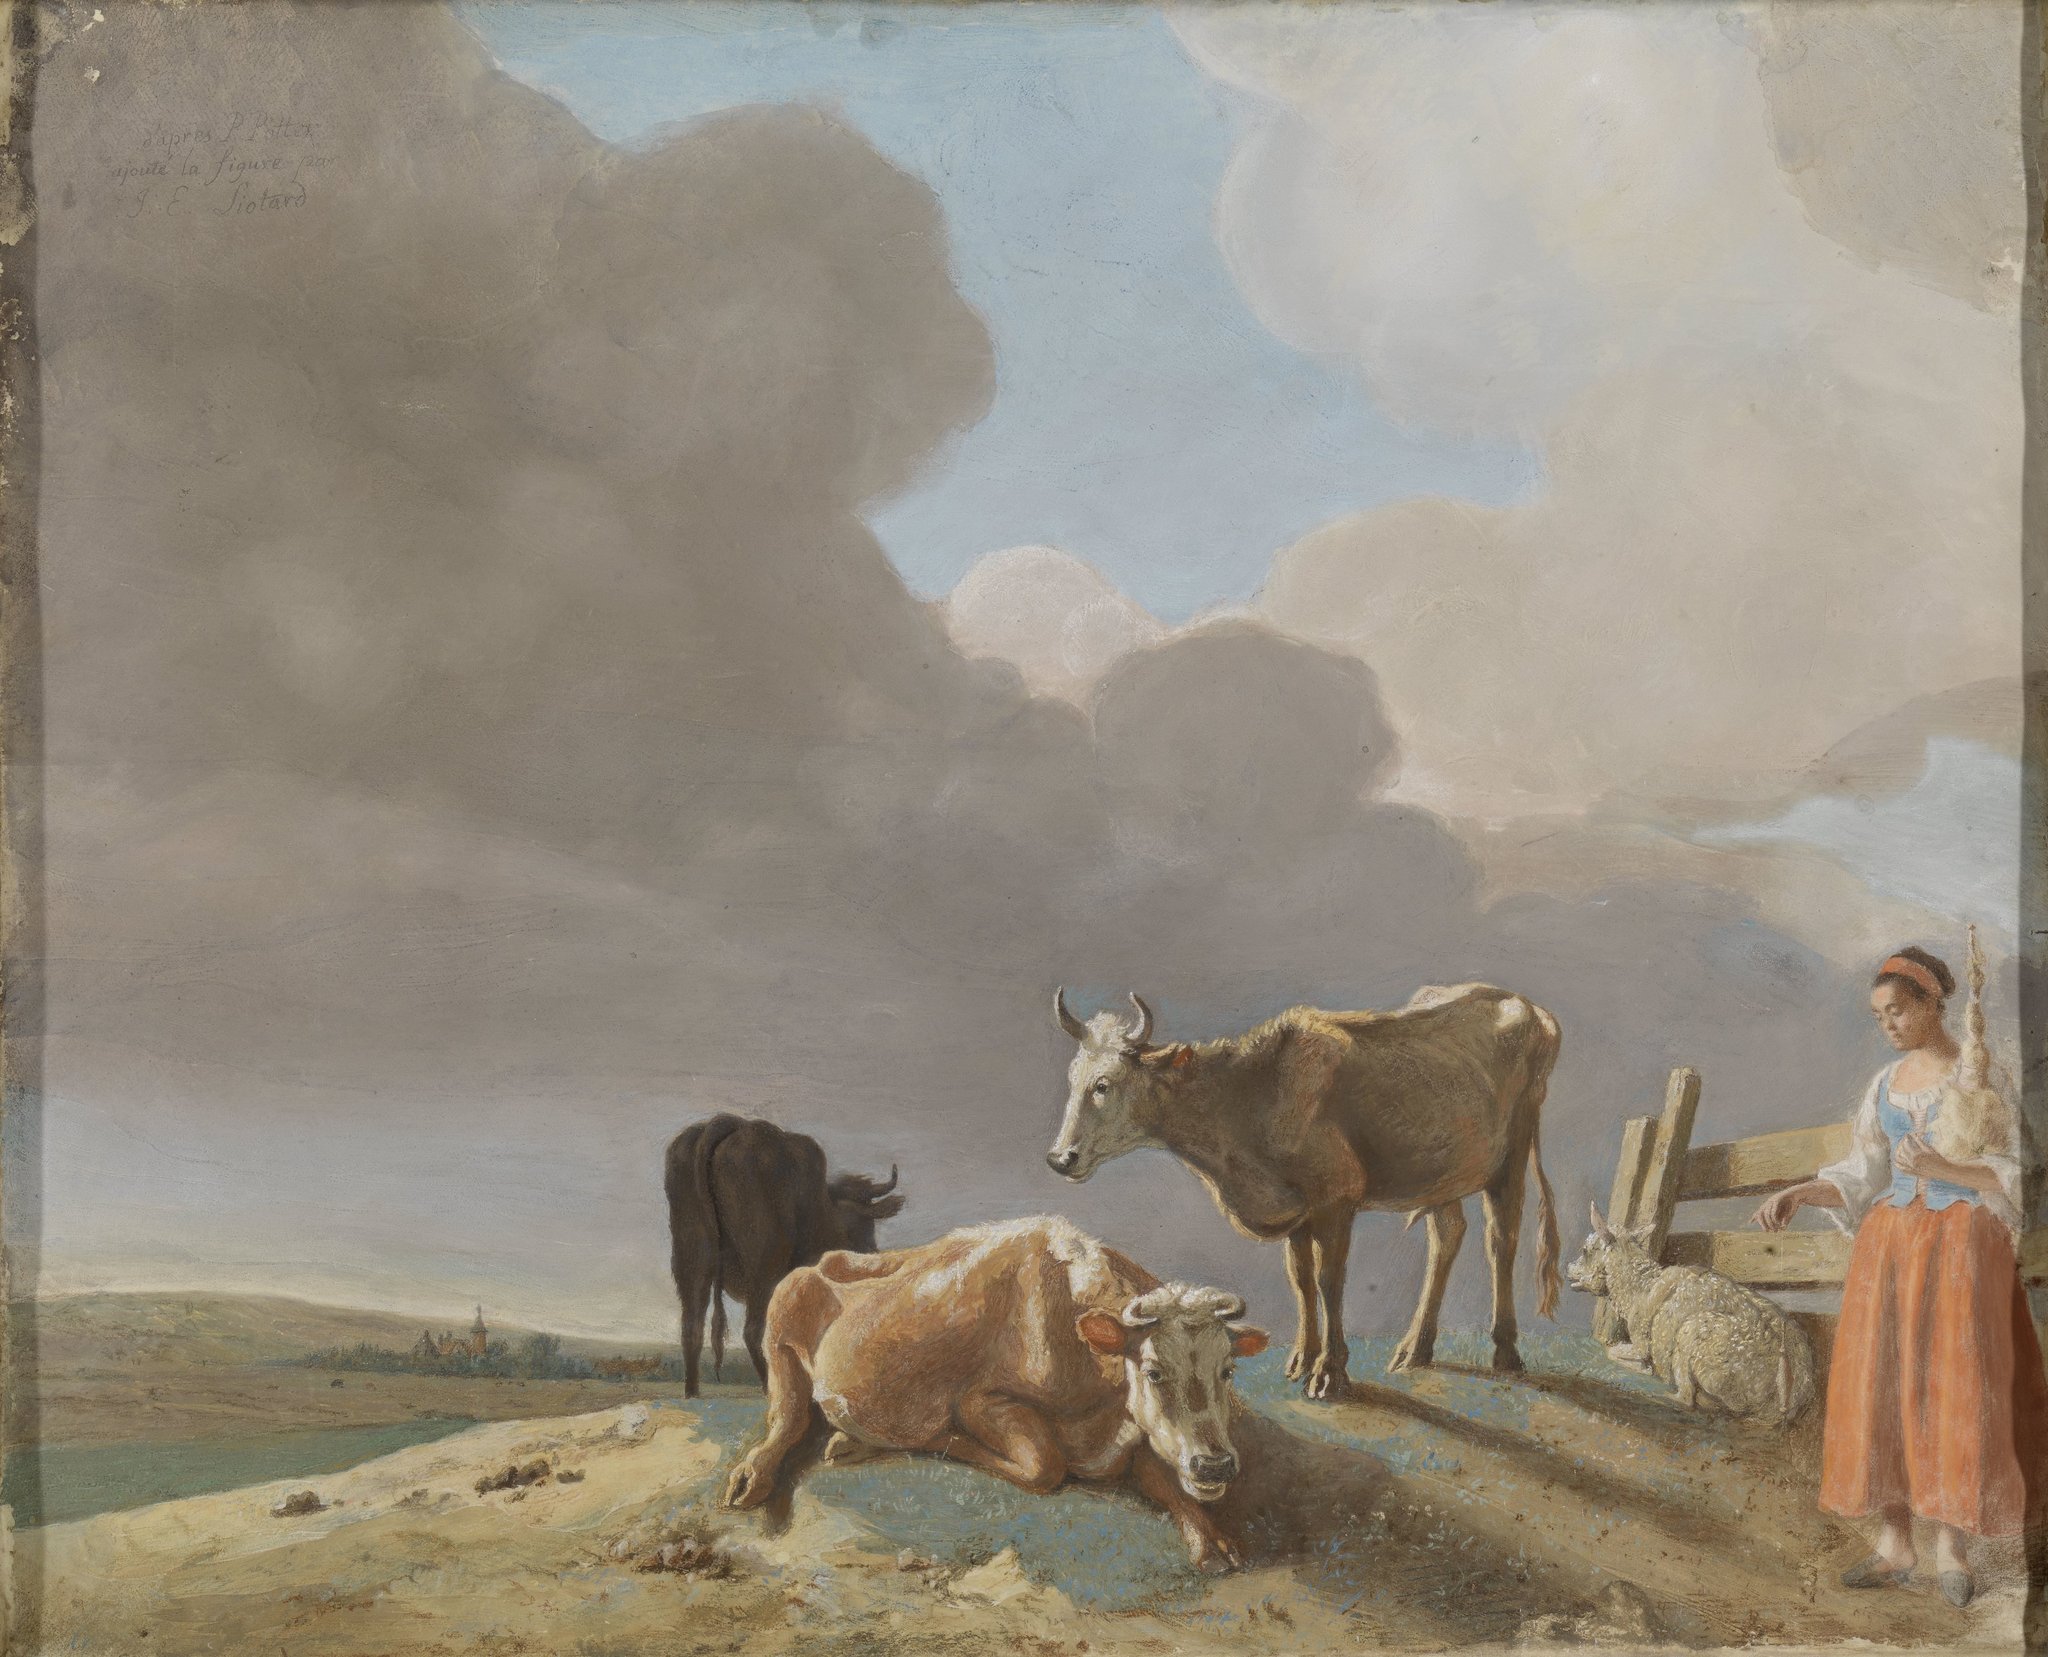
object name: pastel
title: Landschap met koeien, schapen en herderin, gewijzigde kopie naar een schilderij van Paulus Potter, de herderin gekopieerd van een schilderij van Karel Dujardin (recto); onvoltooid portret van een man (verso)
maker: jean-etienne liotard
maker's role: painter, print maker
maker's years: 1702-1789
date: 1761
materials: parchment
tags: cow, spinning (manufacture of yarn)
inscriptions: inscription: ‘d'après P. Potter, ajouté la figure par J.E. Liotard’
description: Jean-Etienne Liotard (1702 - 1789). Unfinished portrait of a man (verso). J.W.R. Tilanus bequest, 1885.